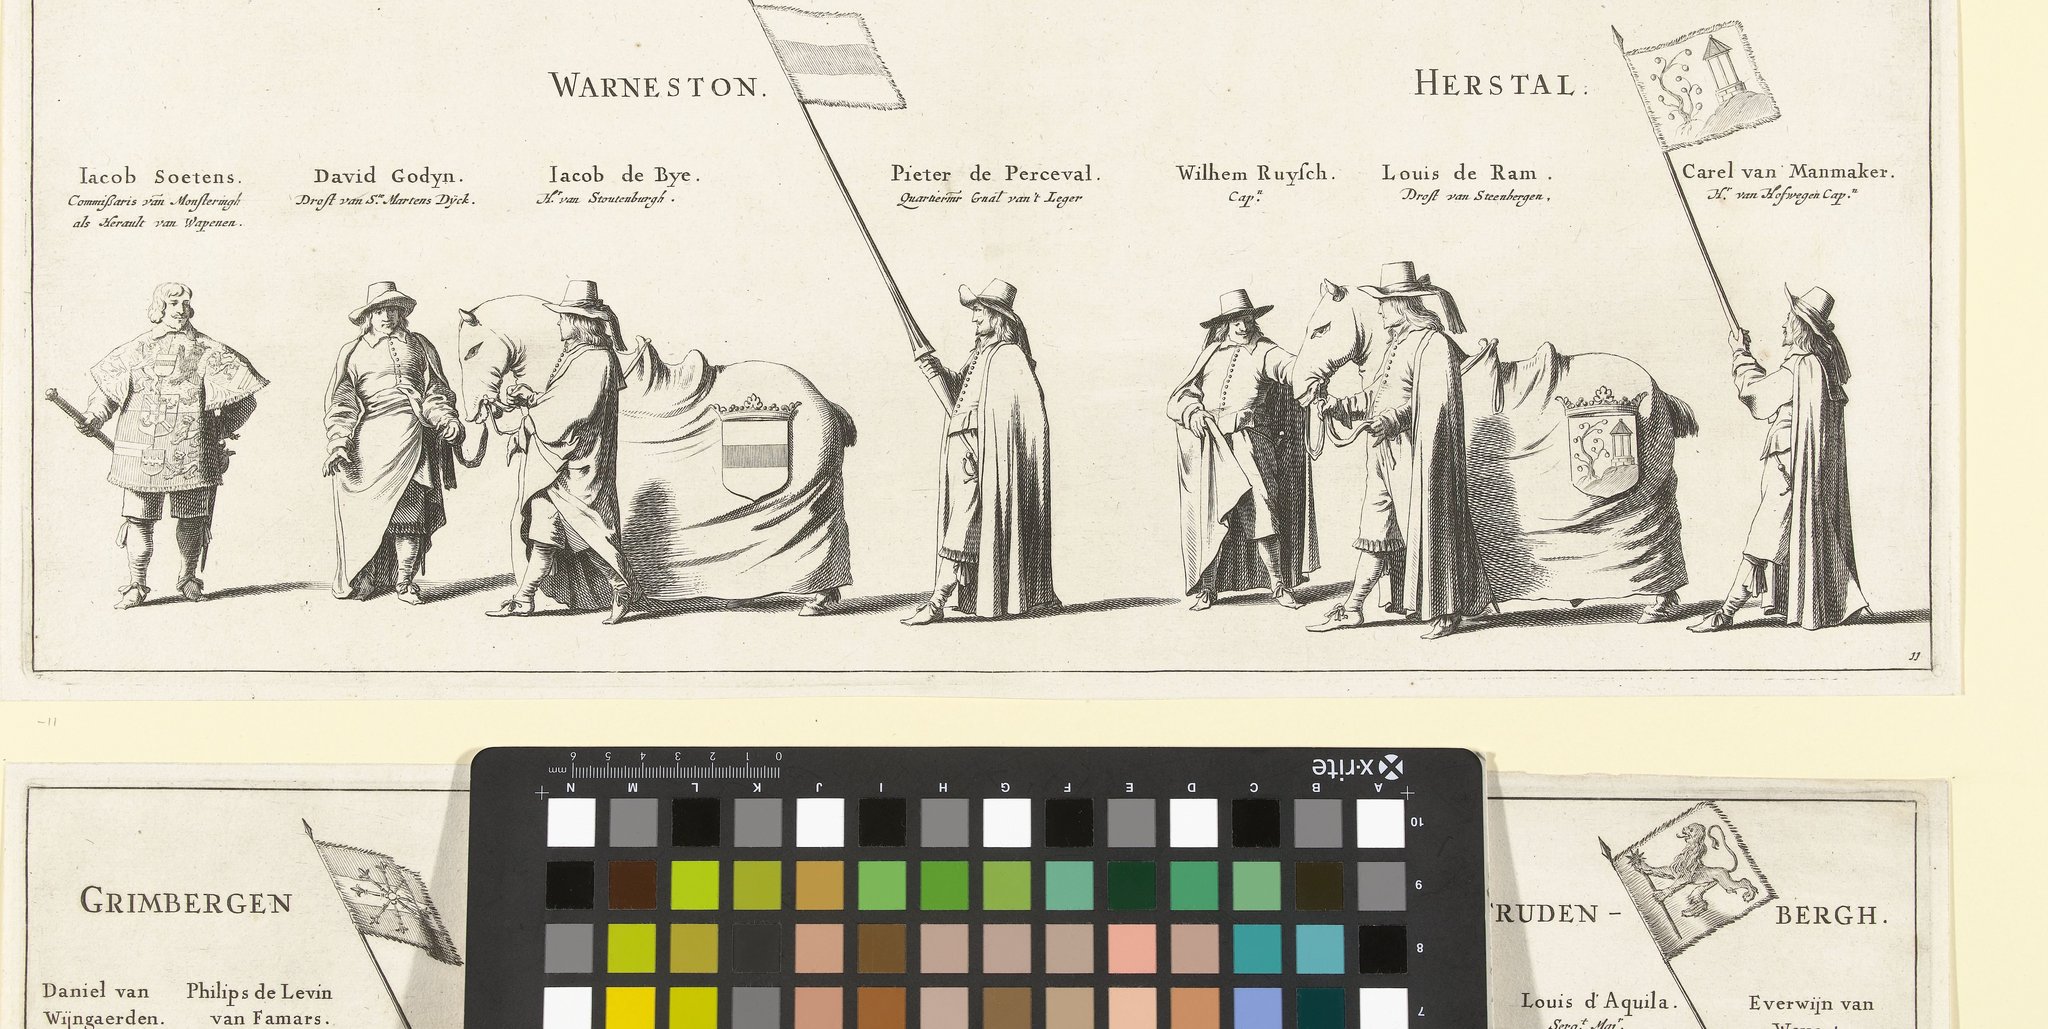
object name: print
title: Begraeffenisse van Syne Hoogheyt Frederick Henrick, by der Gratien Gods Prince van Orange, Grave van Nassau &c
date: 1647-1651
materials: paper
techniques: etching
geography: amsterdam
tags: the hague, frederick henry (prince of orange), cortege, funeral procession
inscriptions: collector's mark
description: De begrafenisstoet van stadhouder Frederik Hendrik te 's-Gravenhage op 10 mei 1647. Plaat nr. 11 met een deel van de stoet met vaandeldragers en twee paarden, boven de personen staan hun naam en functie. Onderdeel van een serie van 30 platen en 20 tekstbladen, bedoeld om aan elkaar geplakt te worden.